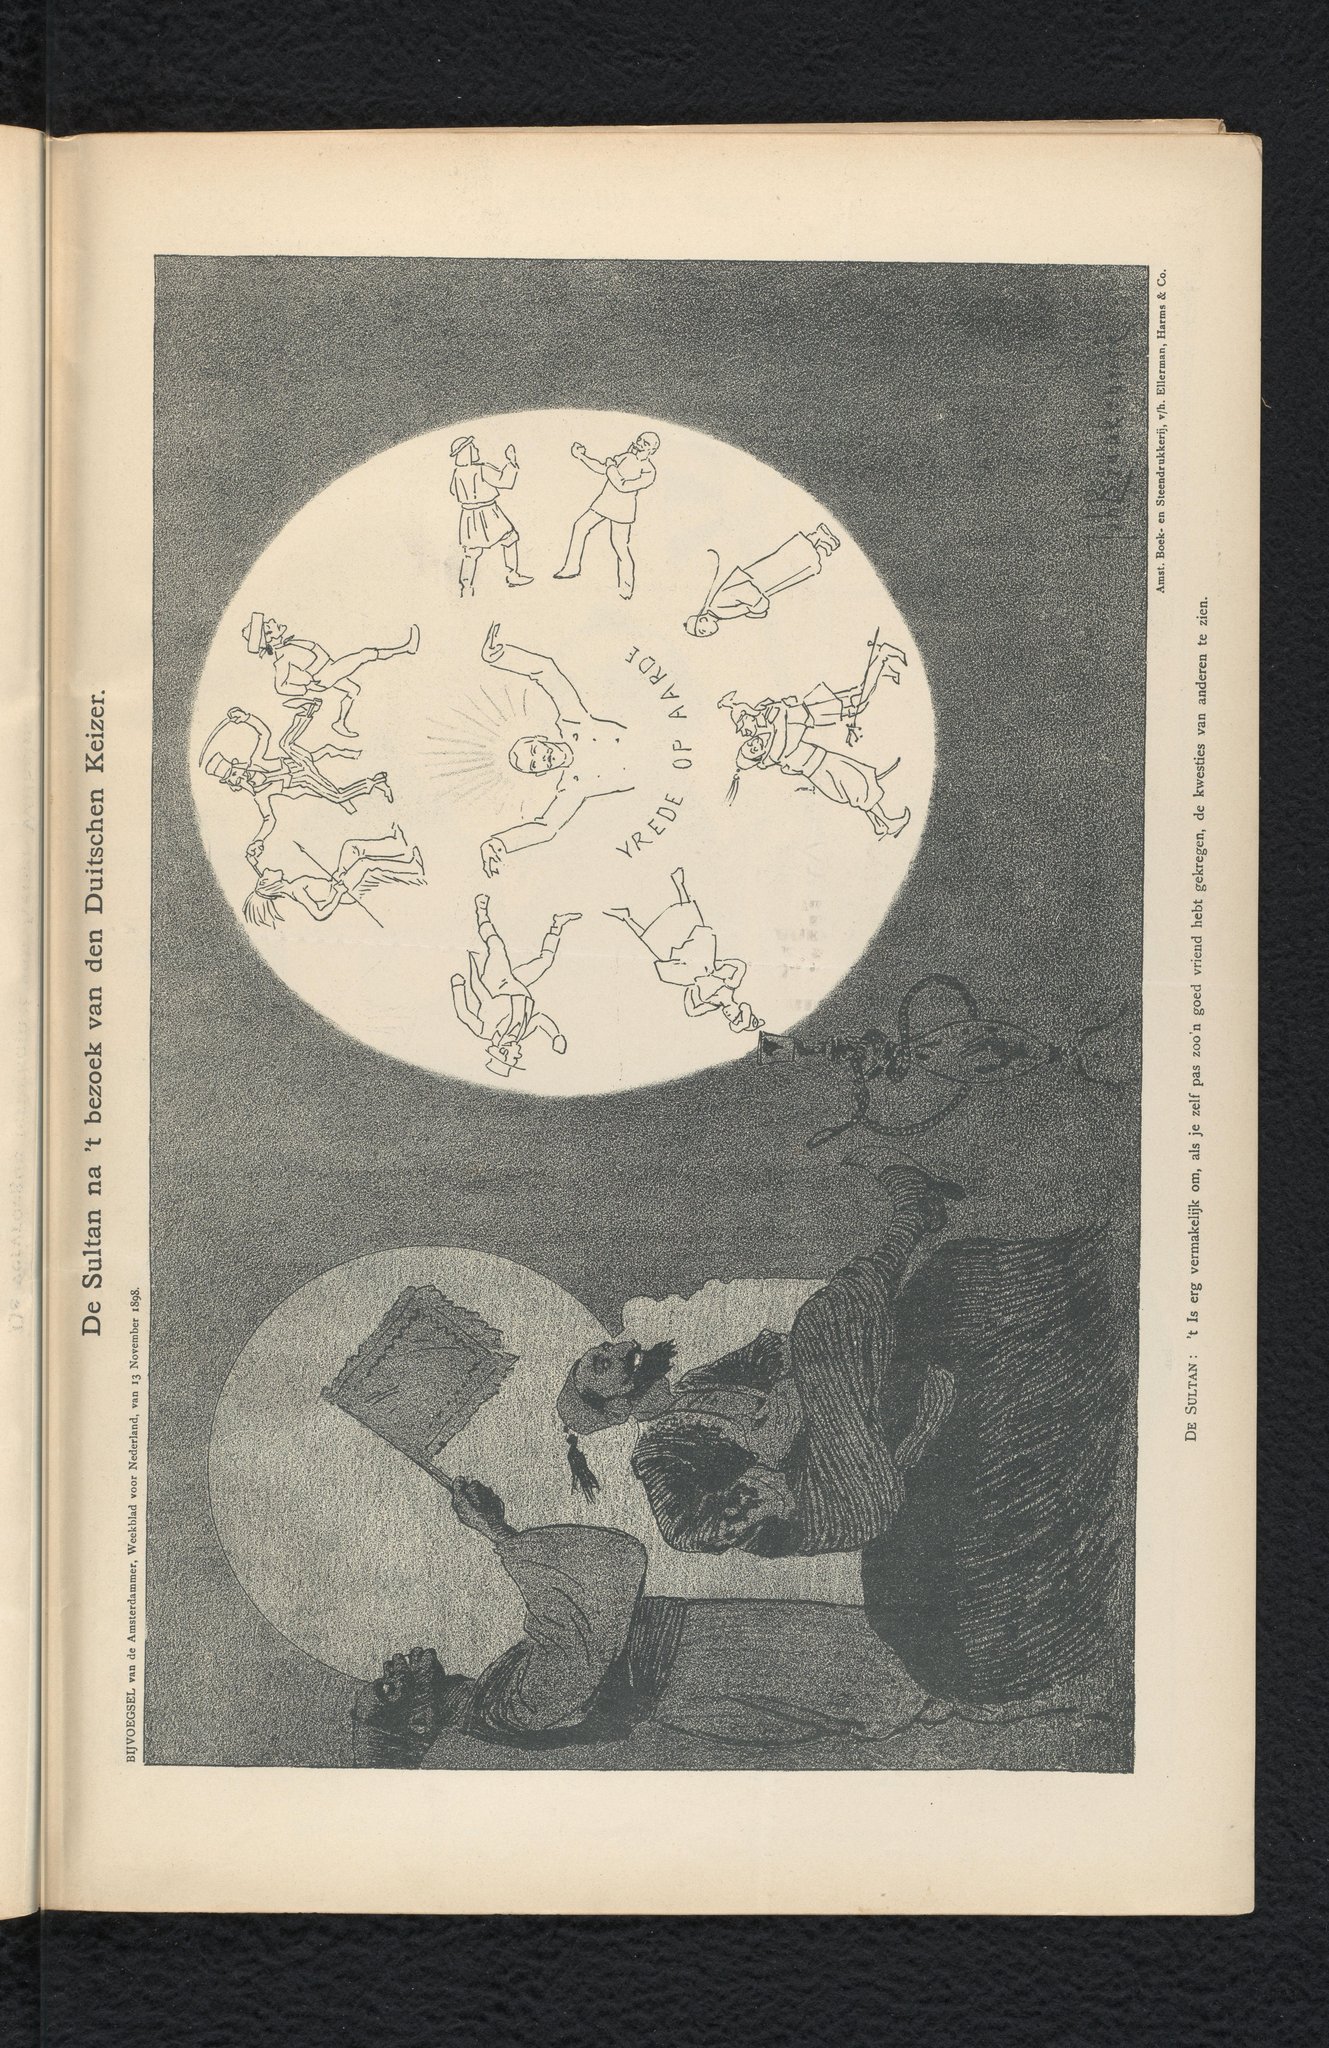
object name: cartoon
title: De Sultan na 't bezoek van den Duitschen Keizer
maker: johan braakensiek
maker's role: draughtsman, print maker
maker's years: 1858-1940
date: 1898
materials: paper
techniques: lithograph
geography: amsterdam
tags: wilhelm ii (keizer van duitsland), personifications of countries, nations, states, districts, etc., transparency, slide, magic lantern, political caricatures and satires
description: Sultan Abdülhamid II bekijkt met plezier een toverlantaarnvoorstelling met een plaatje van de Duitse keizer Wilhelm II die 'vrede op aarde' bepleit terwijl alle landen met elkaar ruziemaken.